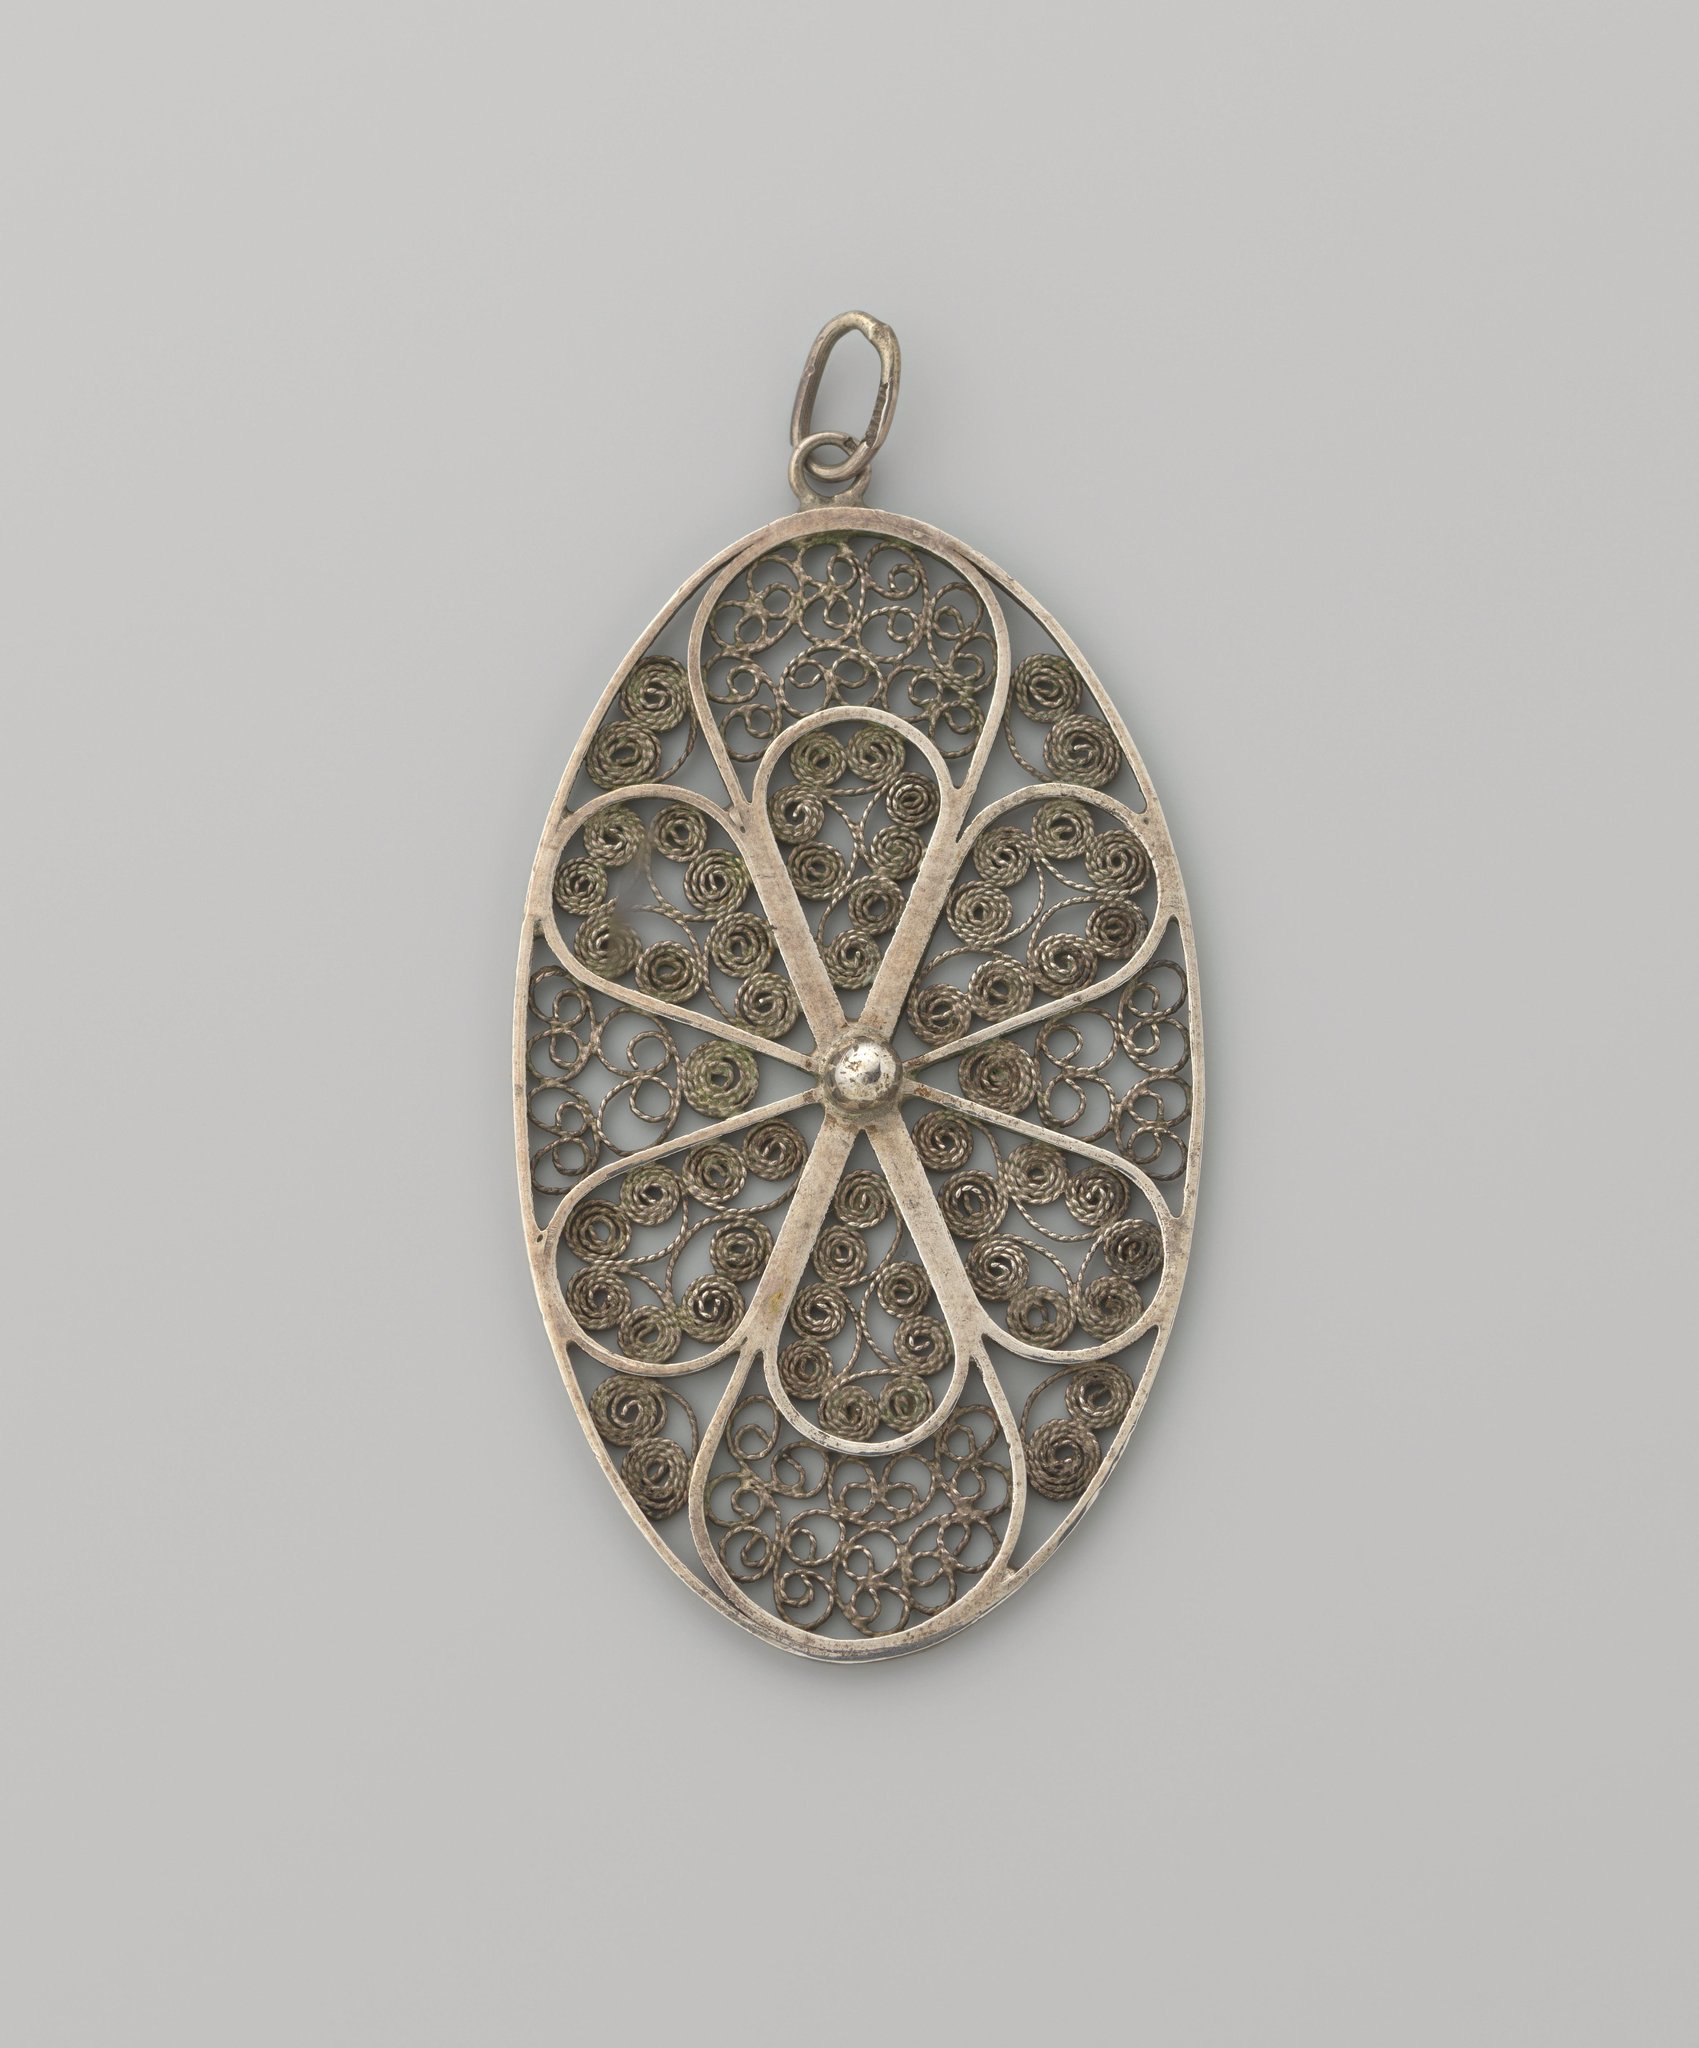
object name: pendant jewelry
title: Ovale hanger van filigrein in zilver met symmetrische lussen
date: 1930-1950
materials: silver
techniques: filigree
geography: amsterdam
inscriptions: maker's mark: ‘JdV6’, : ‘I’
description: Ovale hanger van filigrein in zilver met symmetrische lussen voorzien van een draadoog. De lussen waaieren uit vanaf een centraal geplaatste gladde bol van zilver.